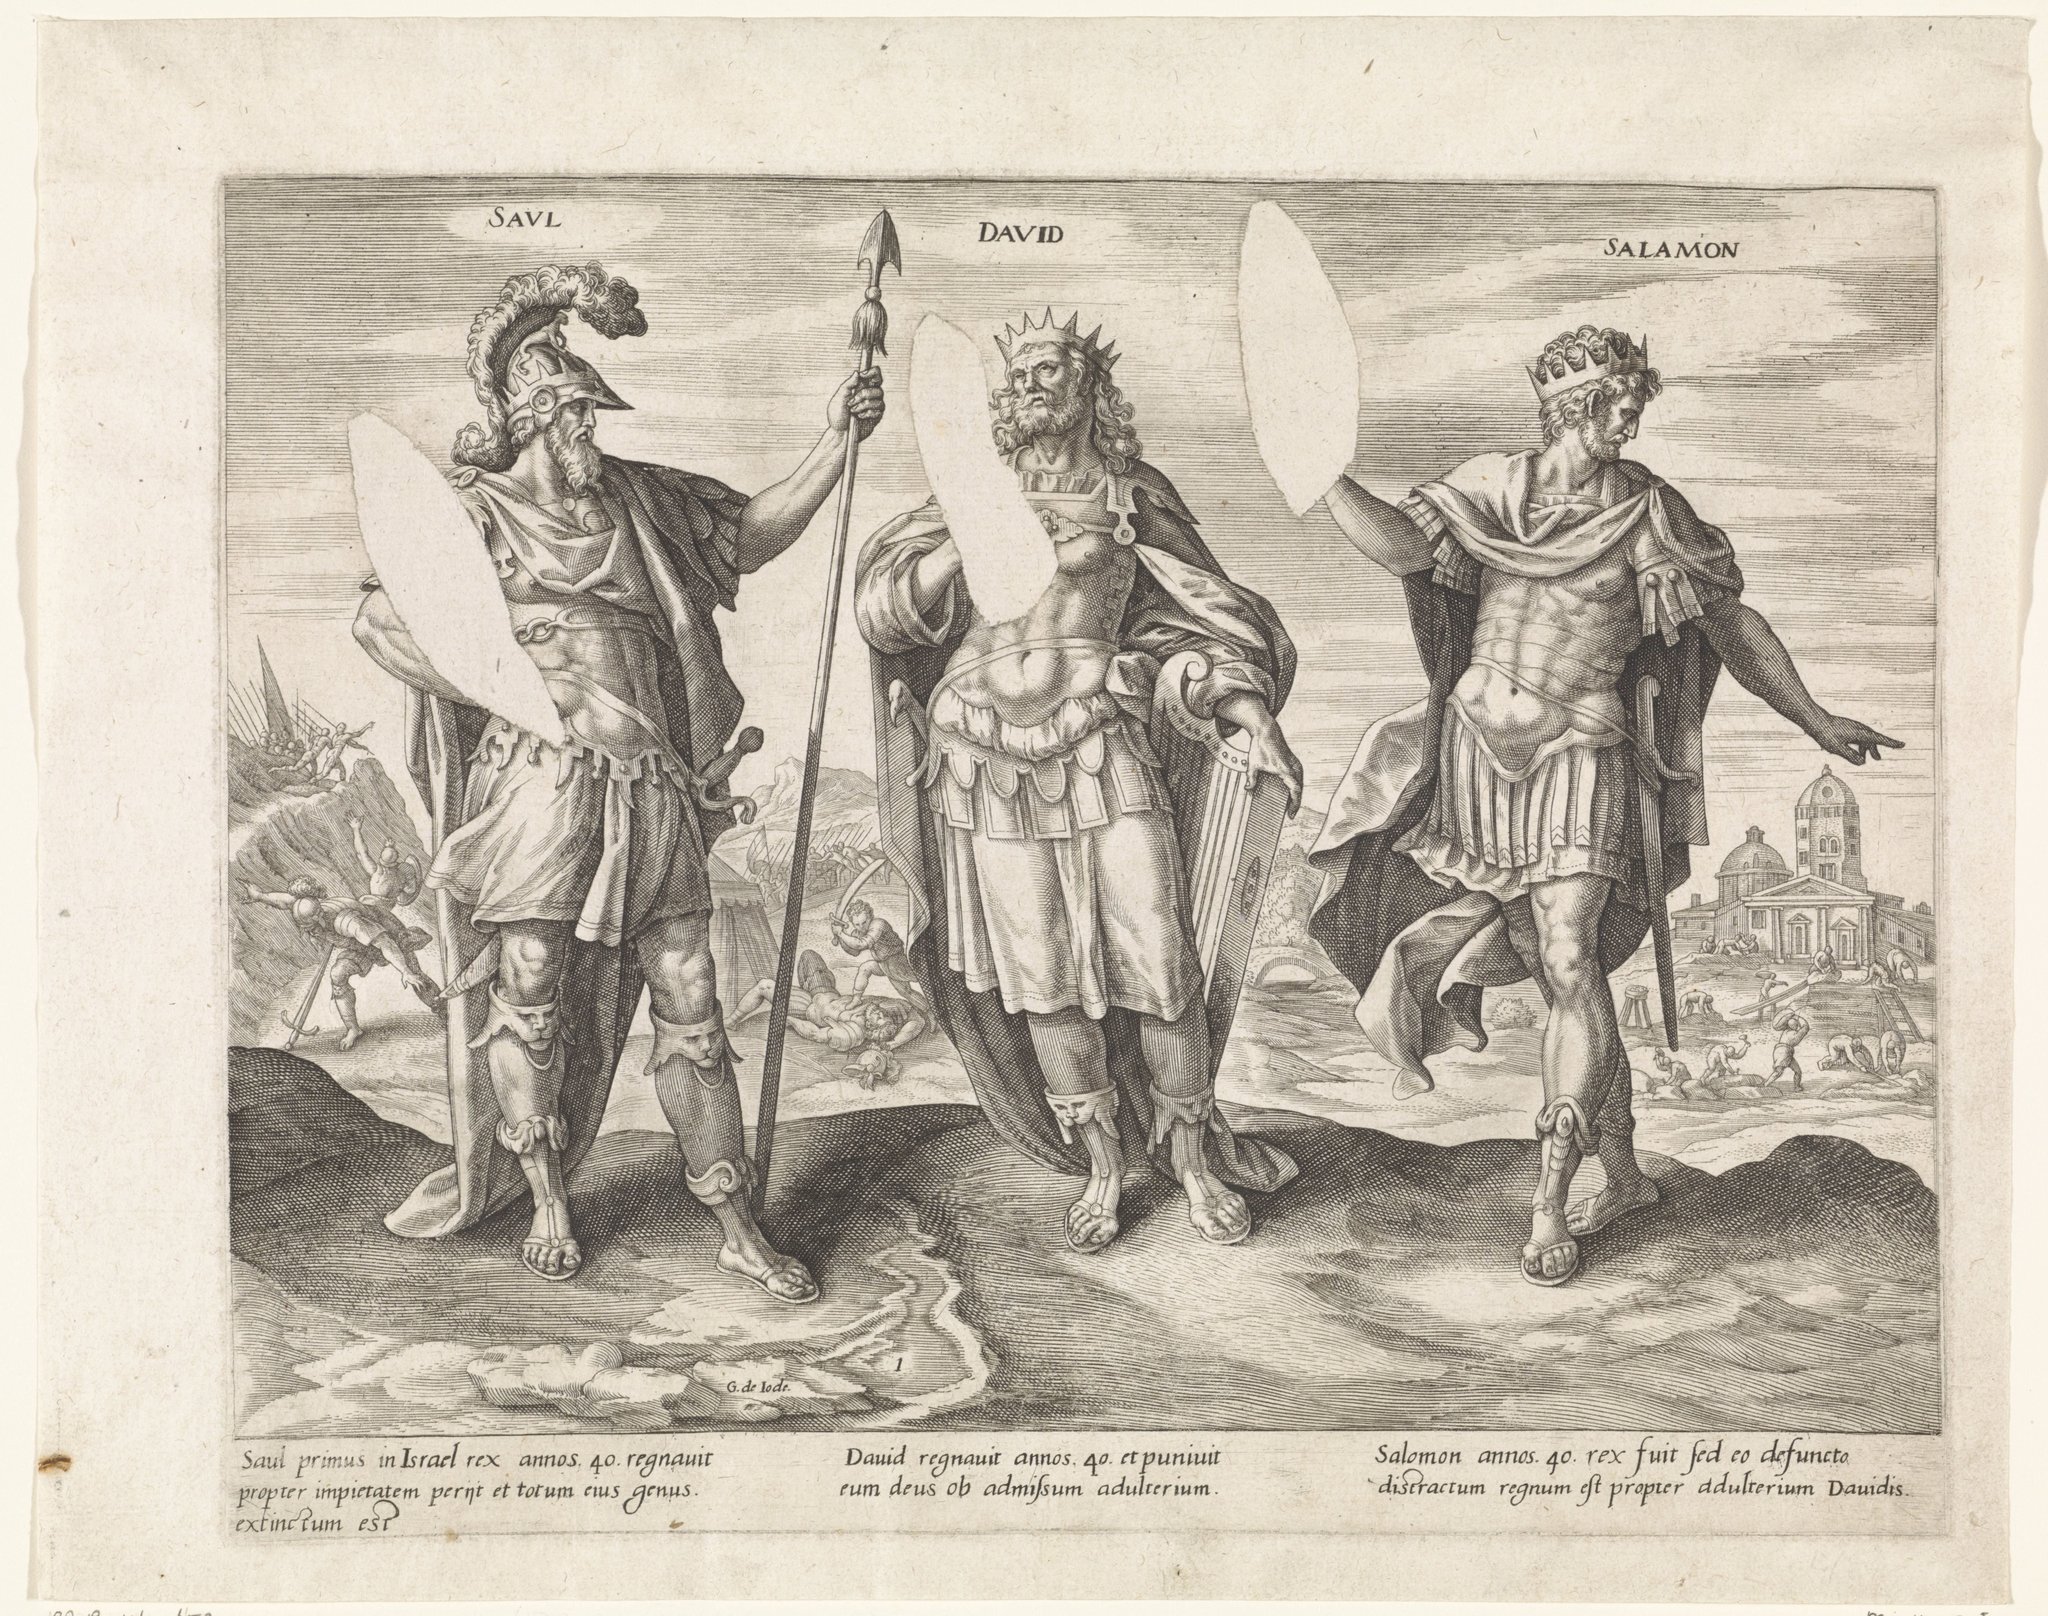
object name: print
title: Thesaurus sacrarum historiarum veteris testamenti (...)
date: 1585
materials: paper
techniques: engraving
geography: antwerp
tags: the construction of the temple of solomon, male persons from the old testament (with name) (not in biblical context), david (not in biblical context); possible attributes: crown, harp, david beheads goliath with a sword, solomon (not in biblical context); possible attributes of solomon: crown, sceptre, sword, saul kills himself with a sword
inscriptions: collector's mark: Lugt 2228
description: De koningen Saul, met speer in de hand, David, met harp in de hand en Salomo. Op de achtergrond belangrijke gebeurtenissen uit hun leven. Links de dood van Saul: hij stort zich in zijn eigen zwaard. Achter David is te zien hoe hij Goliat onthoofdt. Salomo wijst op de bouw van de tempel. Onder de voorstelling toelichtingen in het Latijn.